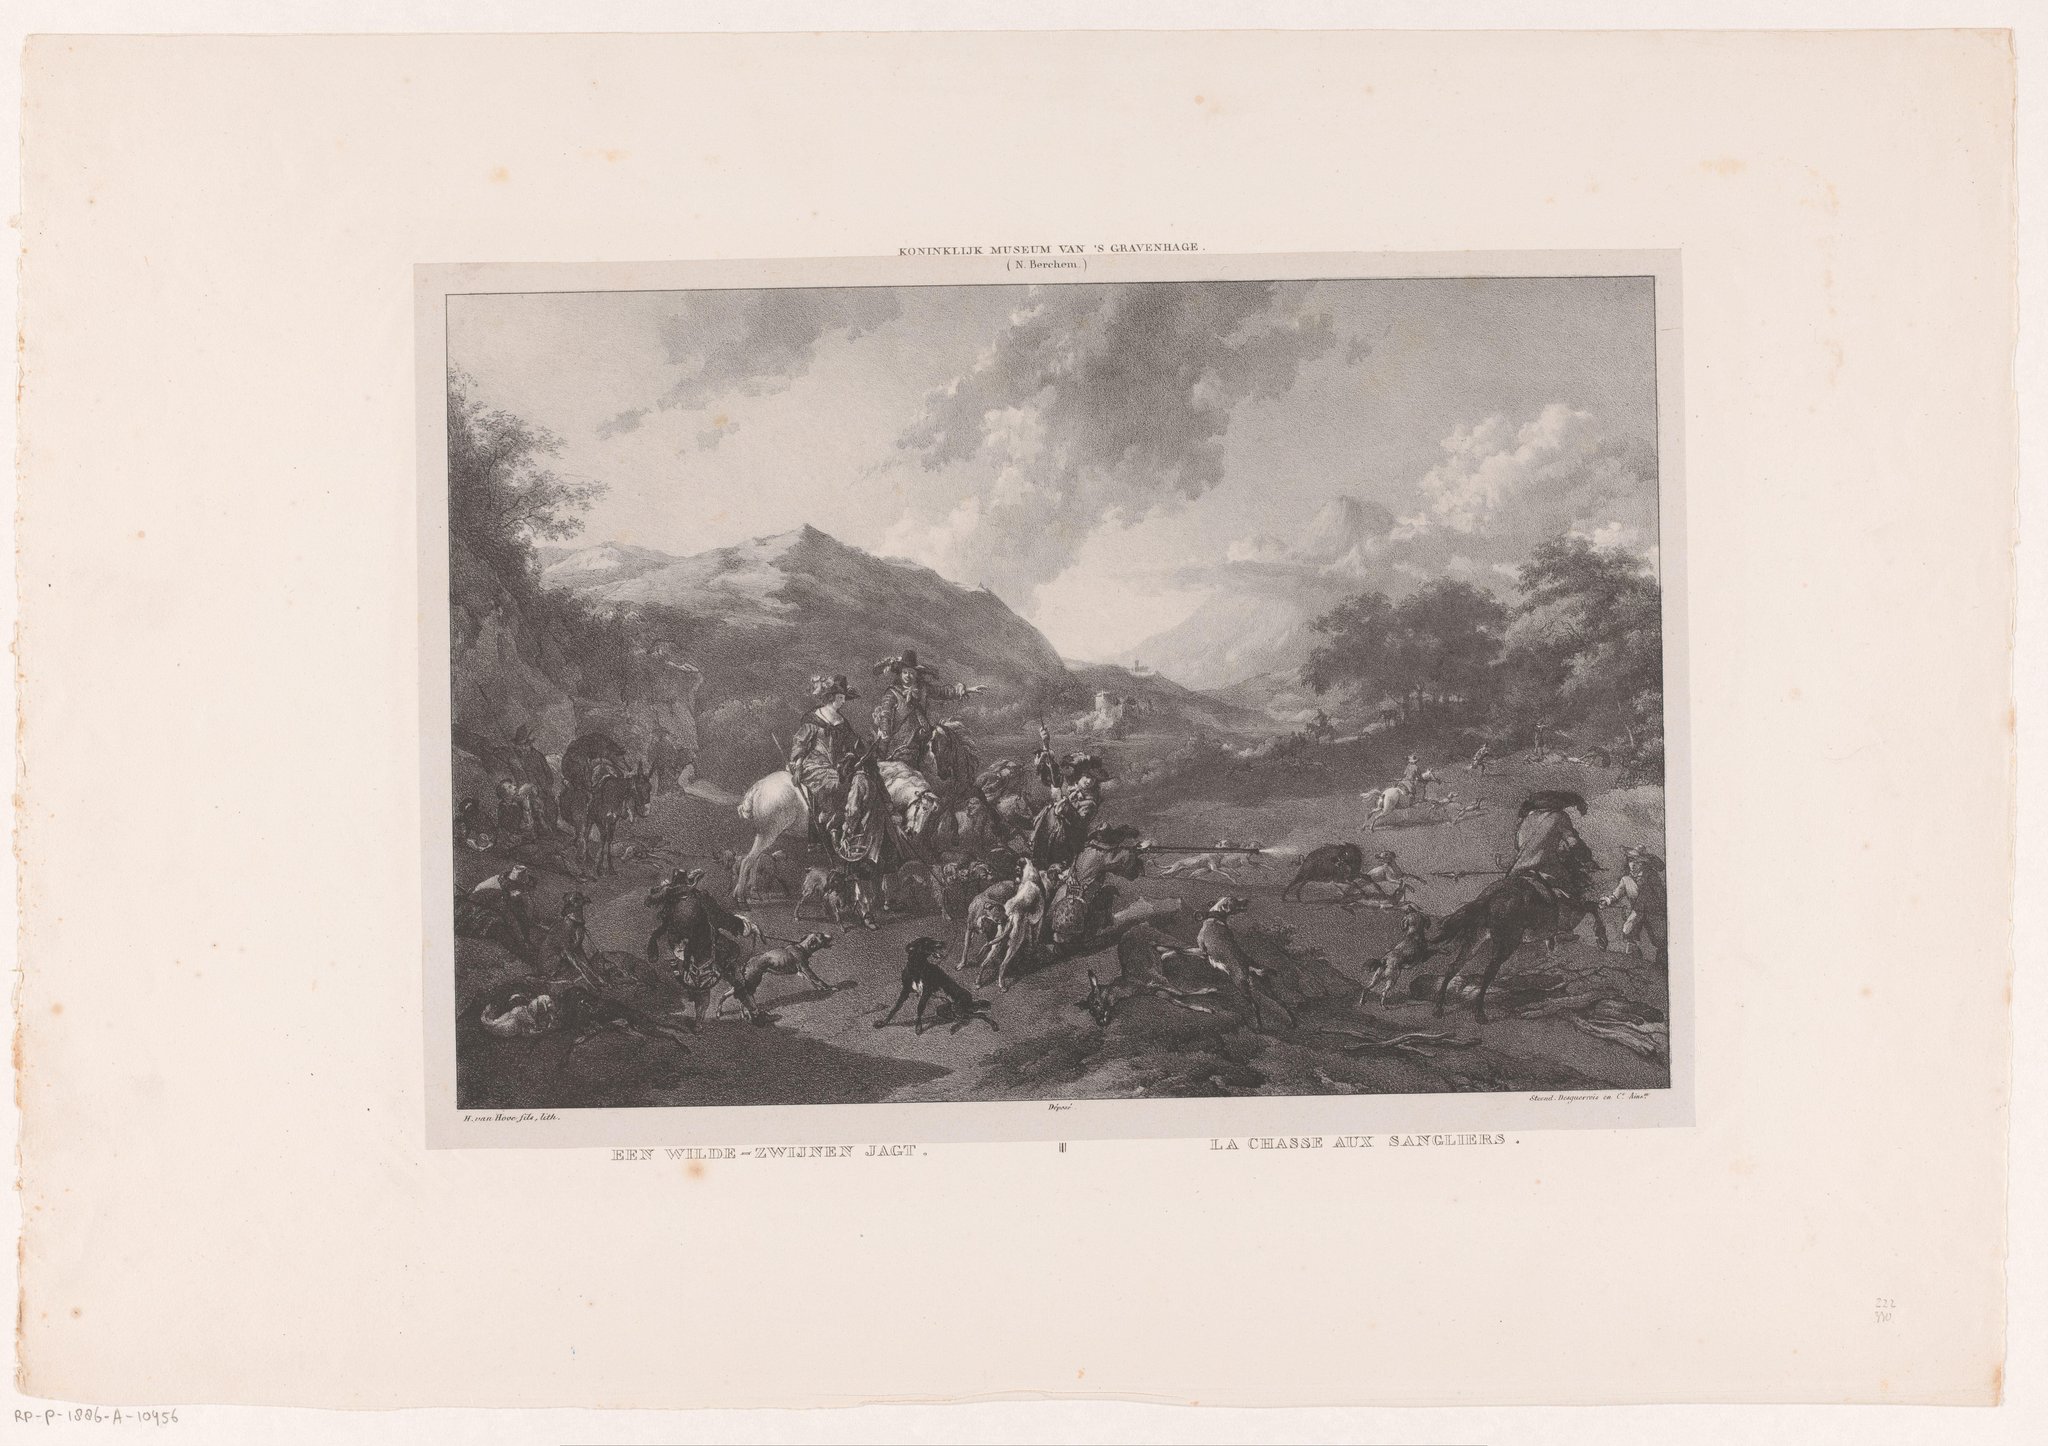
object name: print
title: Wilde zwijnenjacht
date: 1828-1833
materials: paper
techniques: lithograph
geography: amsterdam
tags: hunting dogs, boar-hunting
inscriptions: : ‘Déposé.’, collector's mark: Lugt 2228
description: Drie ruiters en enkele jagers te voeten, begeleid door honden, achtervolgen een wild zwijn. In het midden vuurt een man een geweer af.